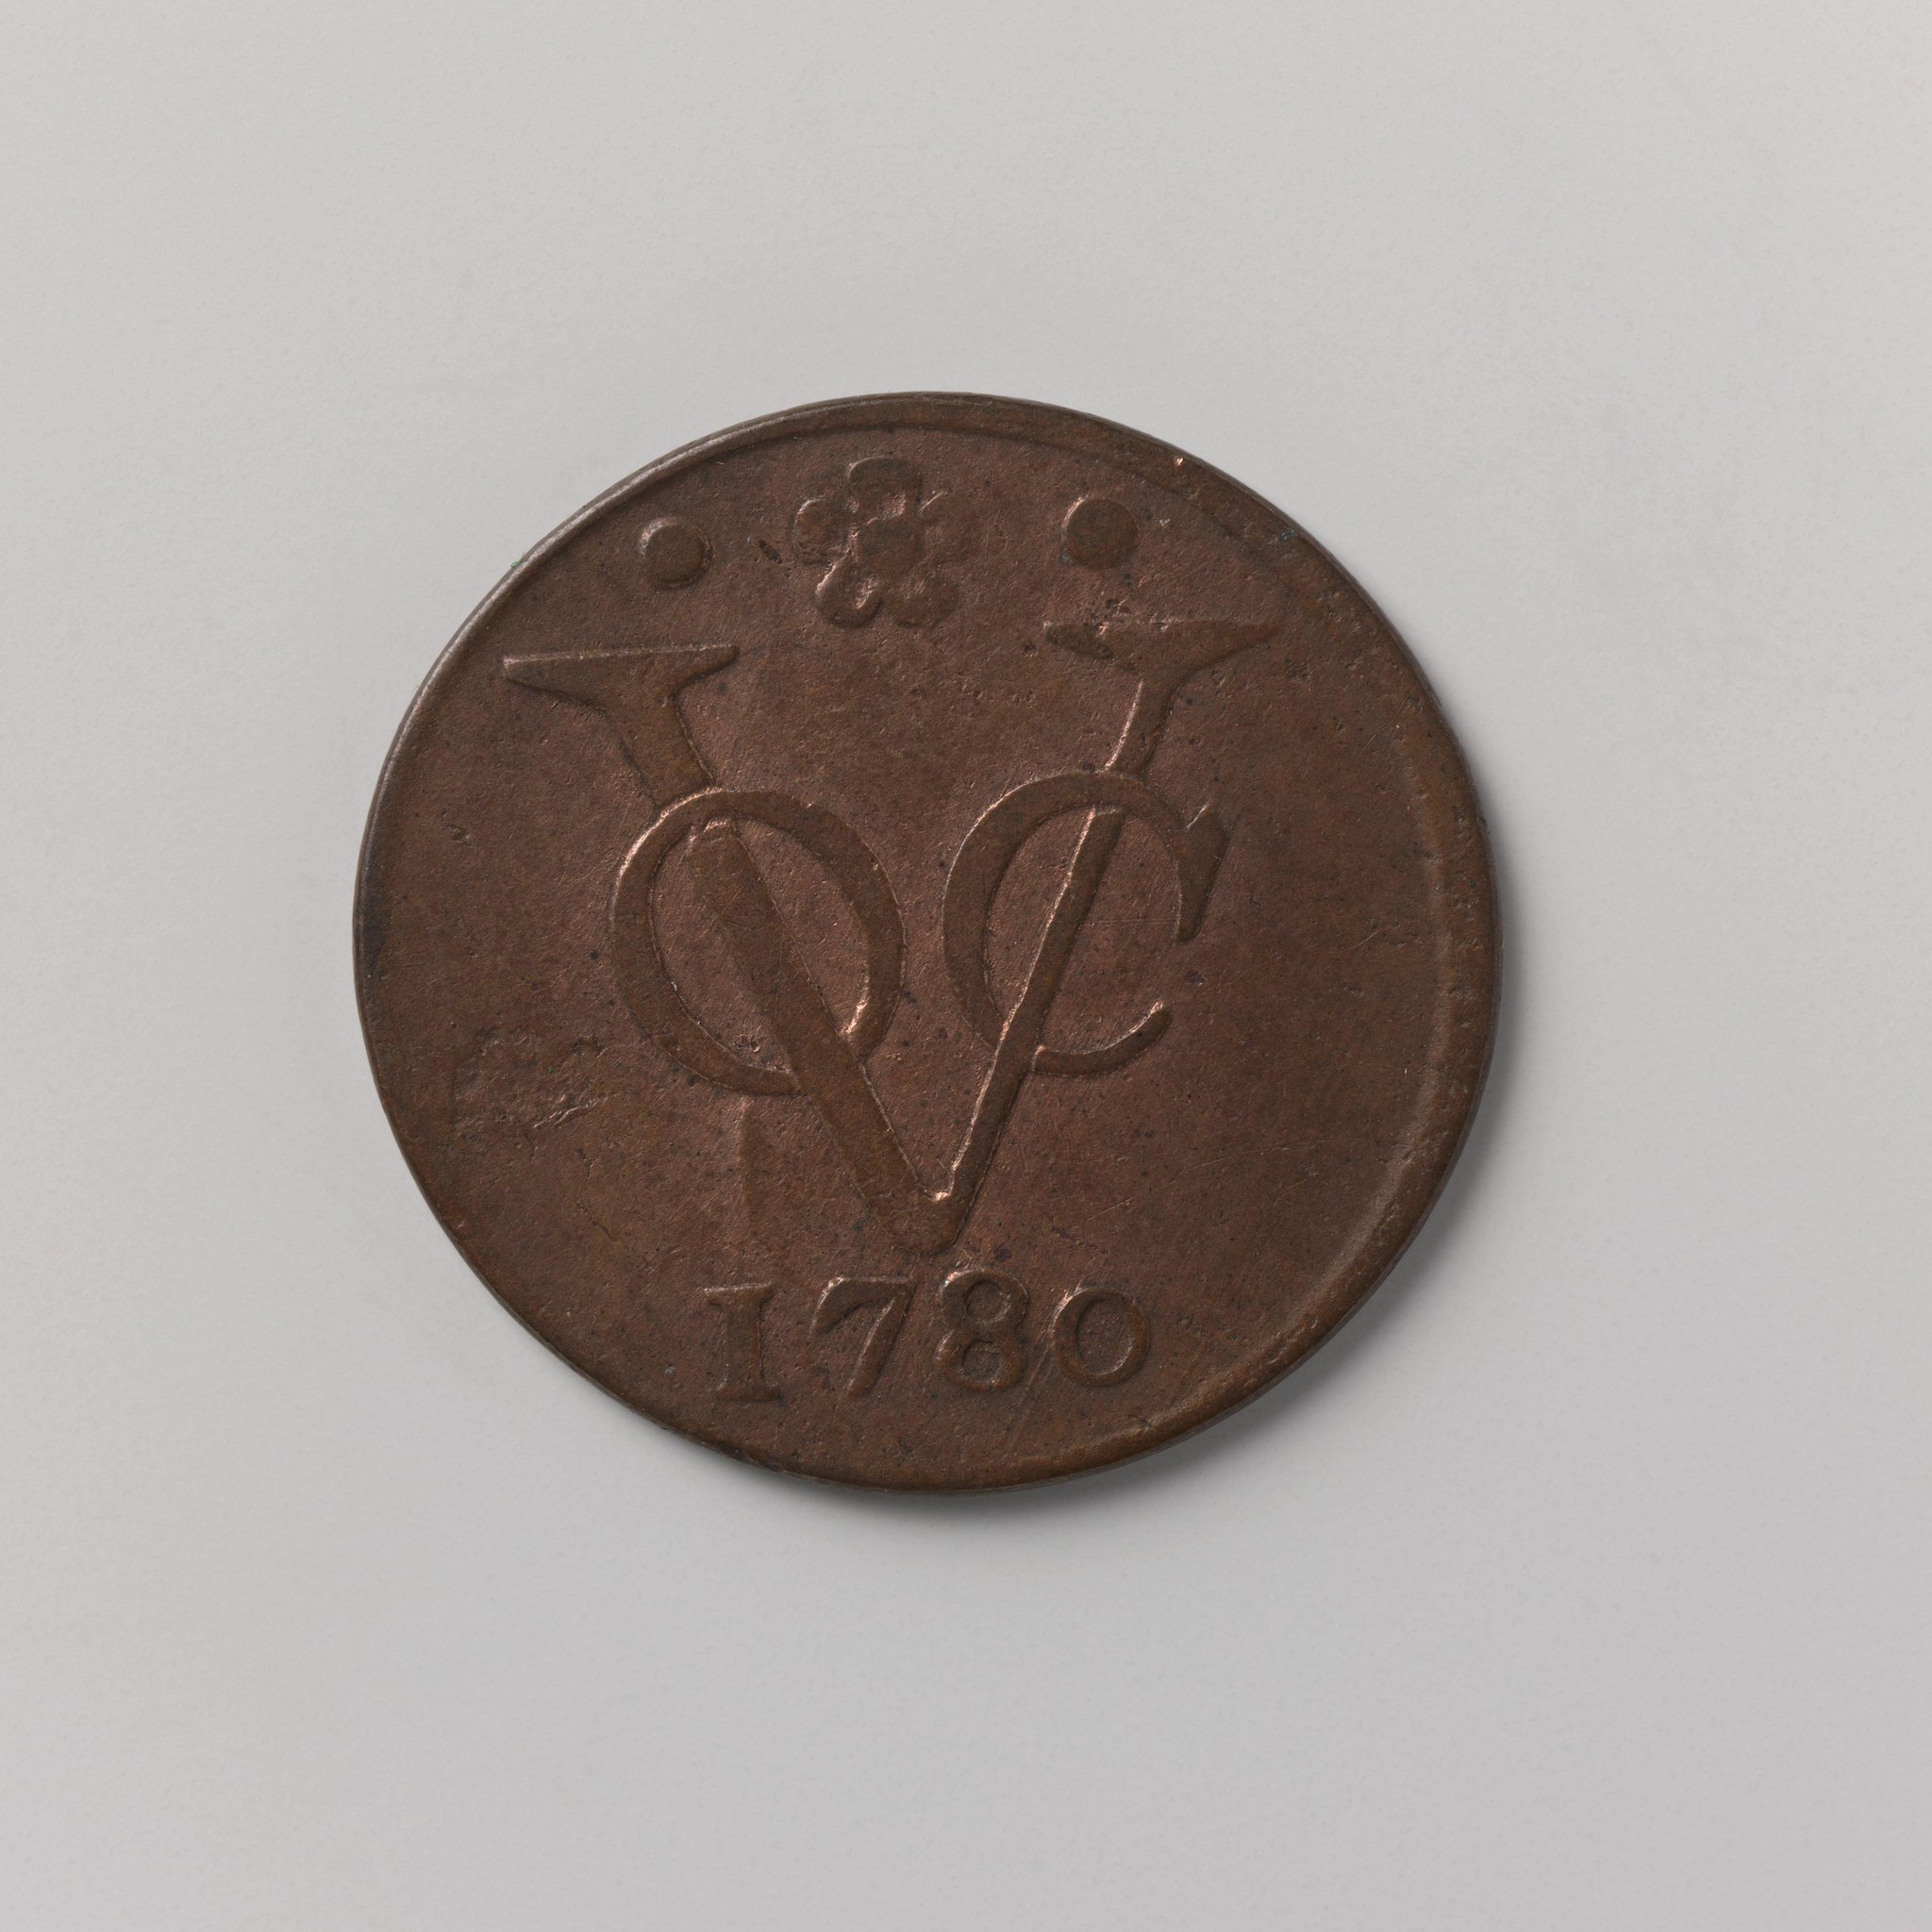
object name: coin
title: VOC, duit Holland, 1780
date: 1780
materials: copper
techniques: striking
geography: dordrecht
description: Koperen munt. Voorzijde: gekroond wapenschild van Holland. Keerzijde: monogram van de VOC, waarboven muntteken en waaronder jaartal. Gladde rand.